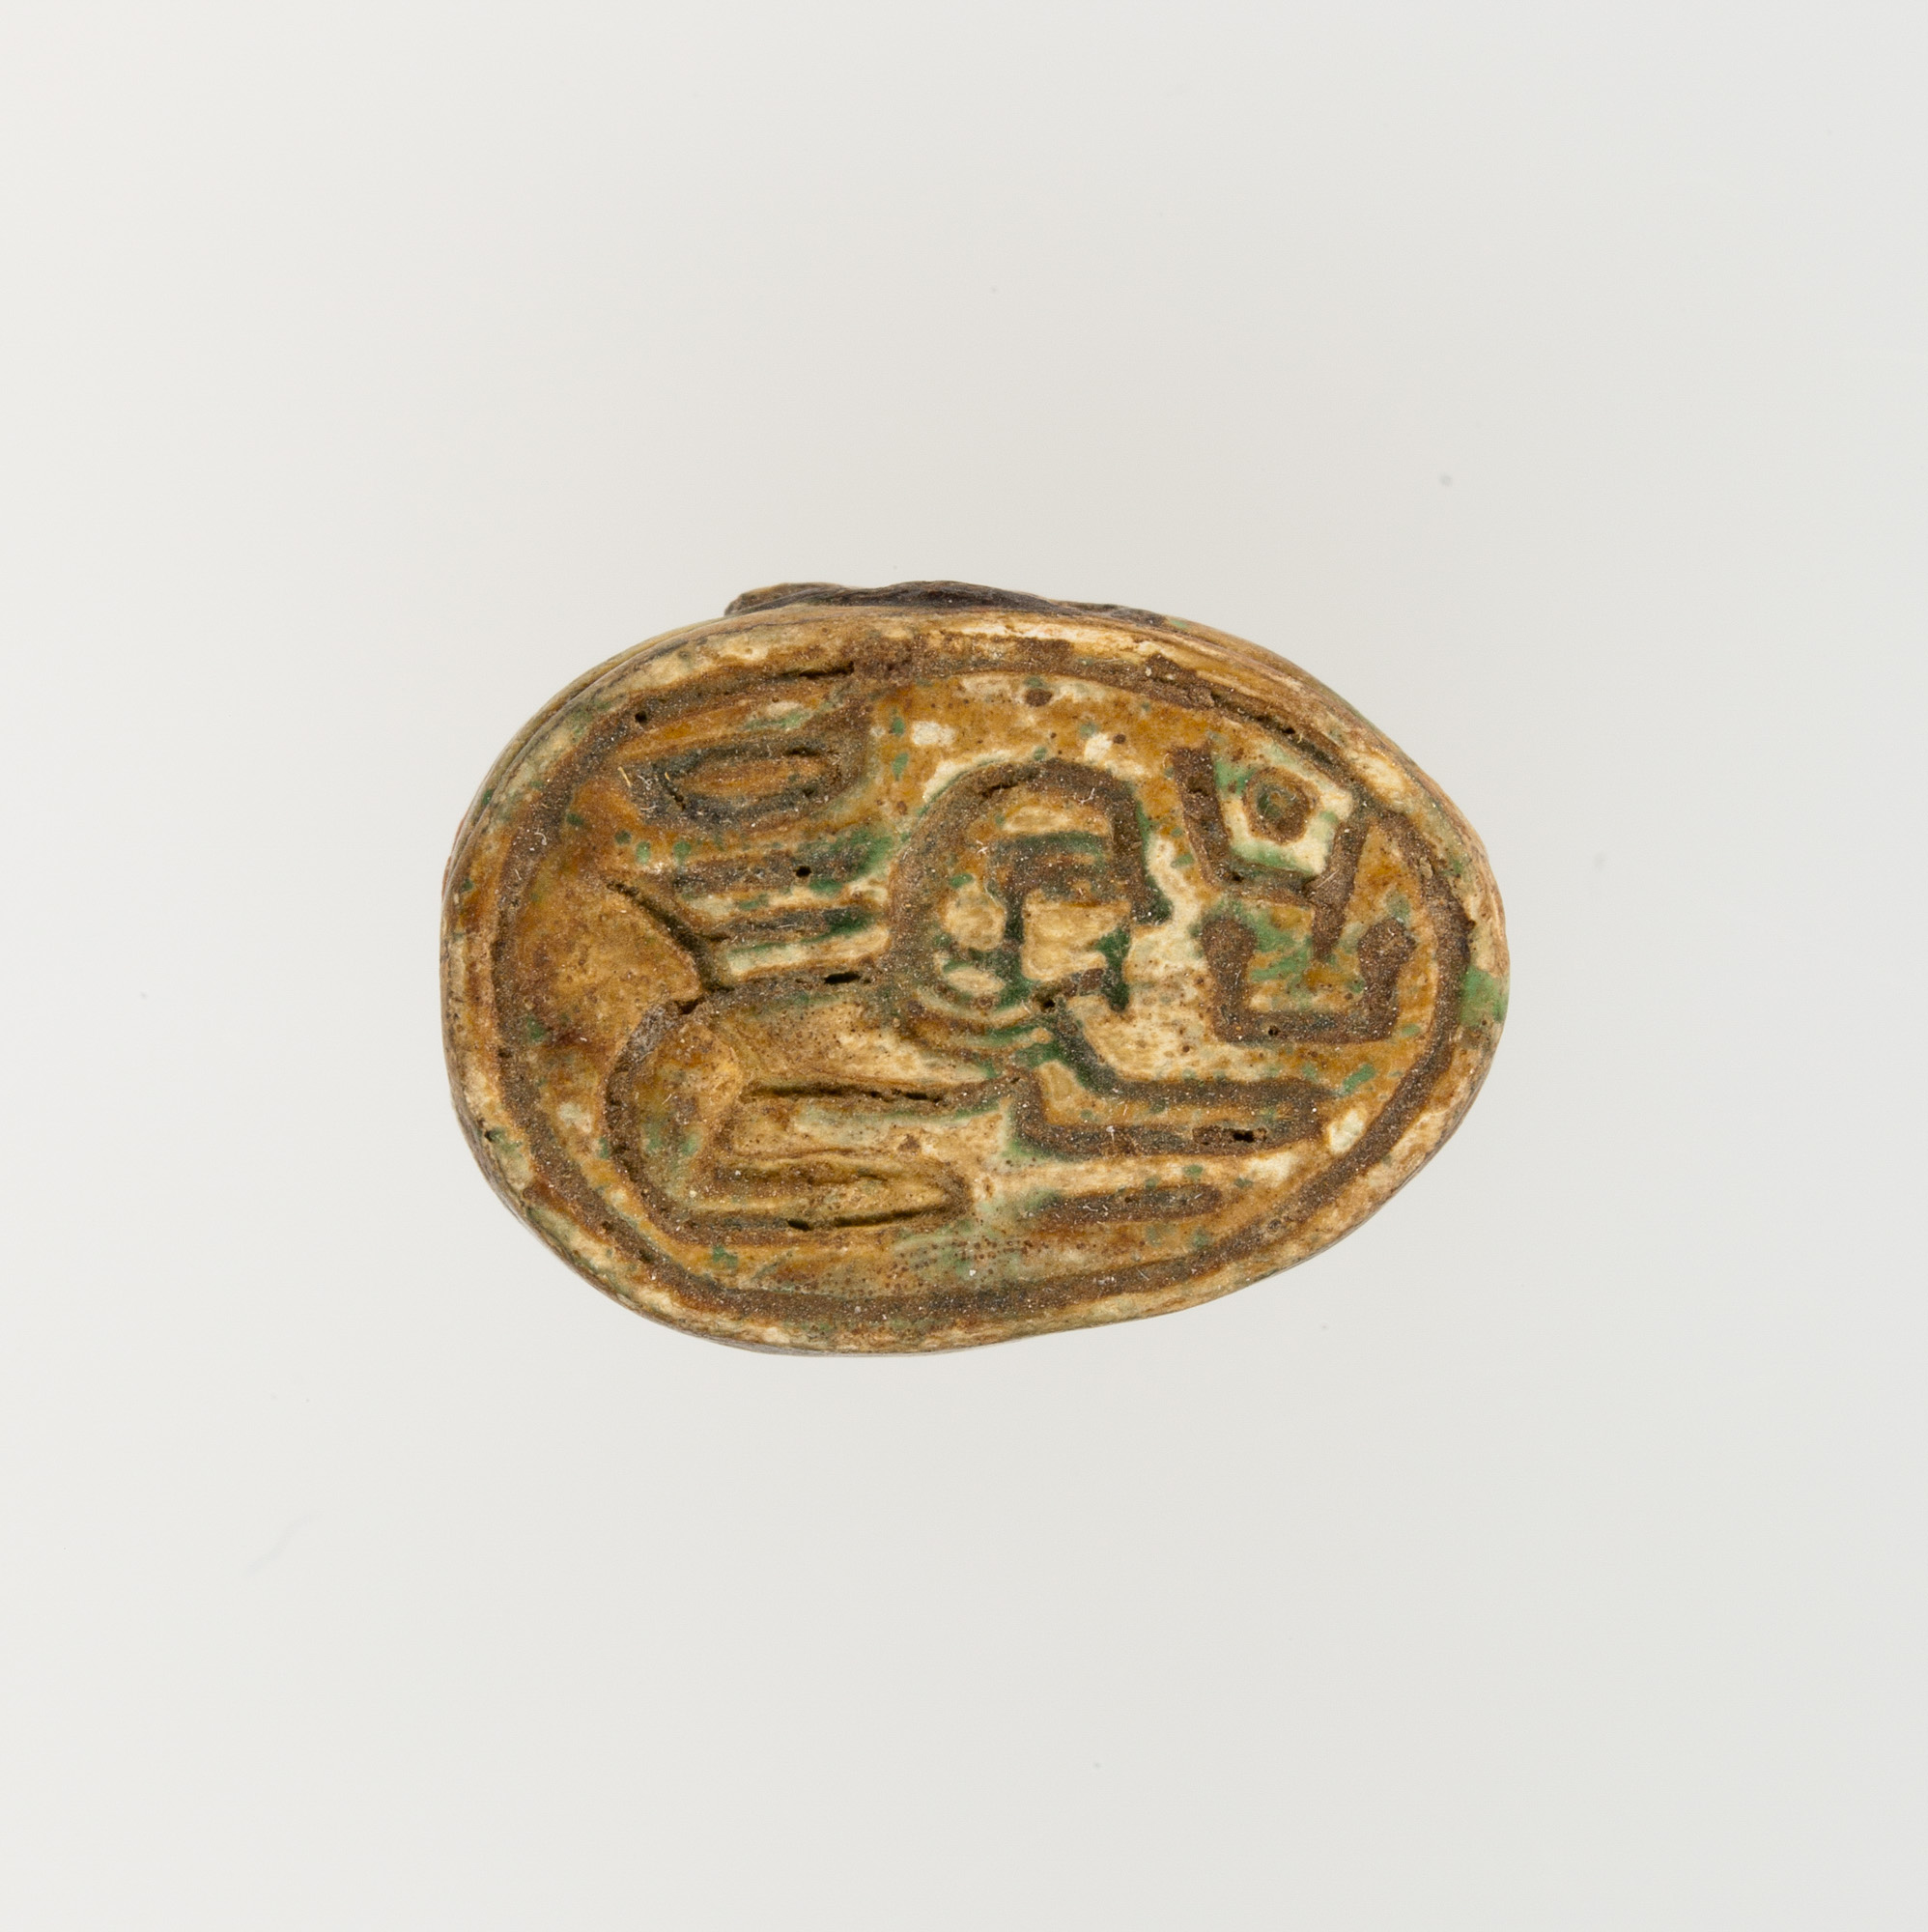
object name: scarab, amenhotep i, djeserkare, sphinx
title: Scarab Inscribed with the Throne Name of Amenhotep I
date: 1525-1504 BCE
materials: stone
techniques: glazing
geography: egypt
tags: hieroglyphs,scarabs